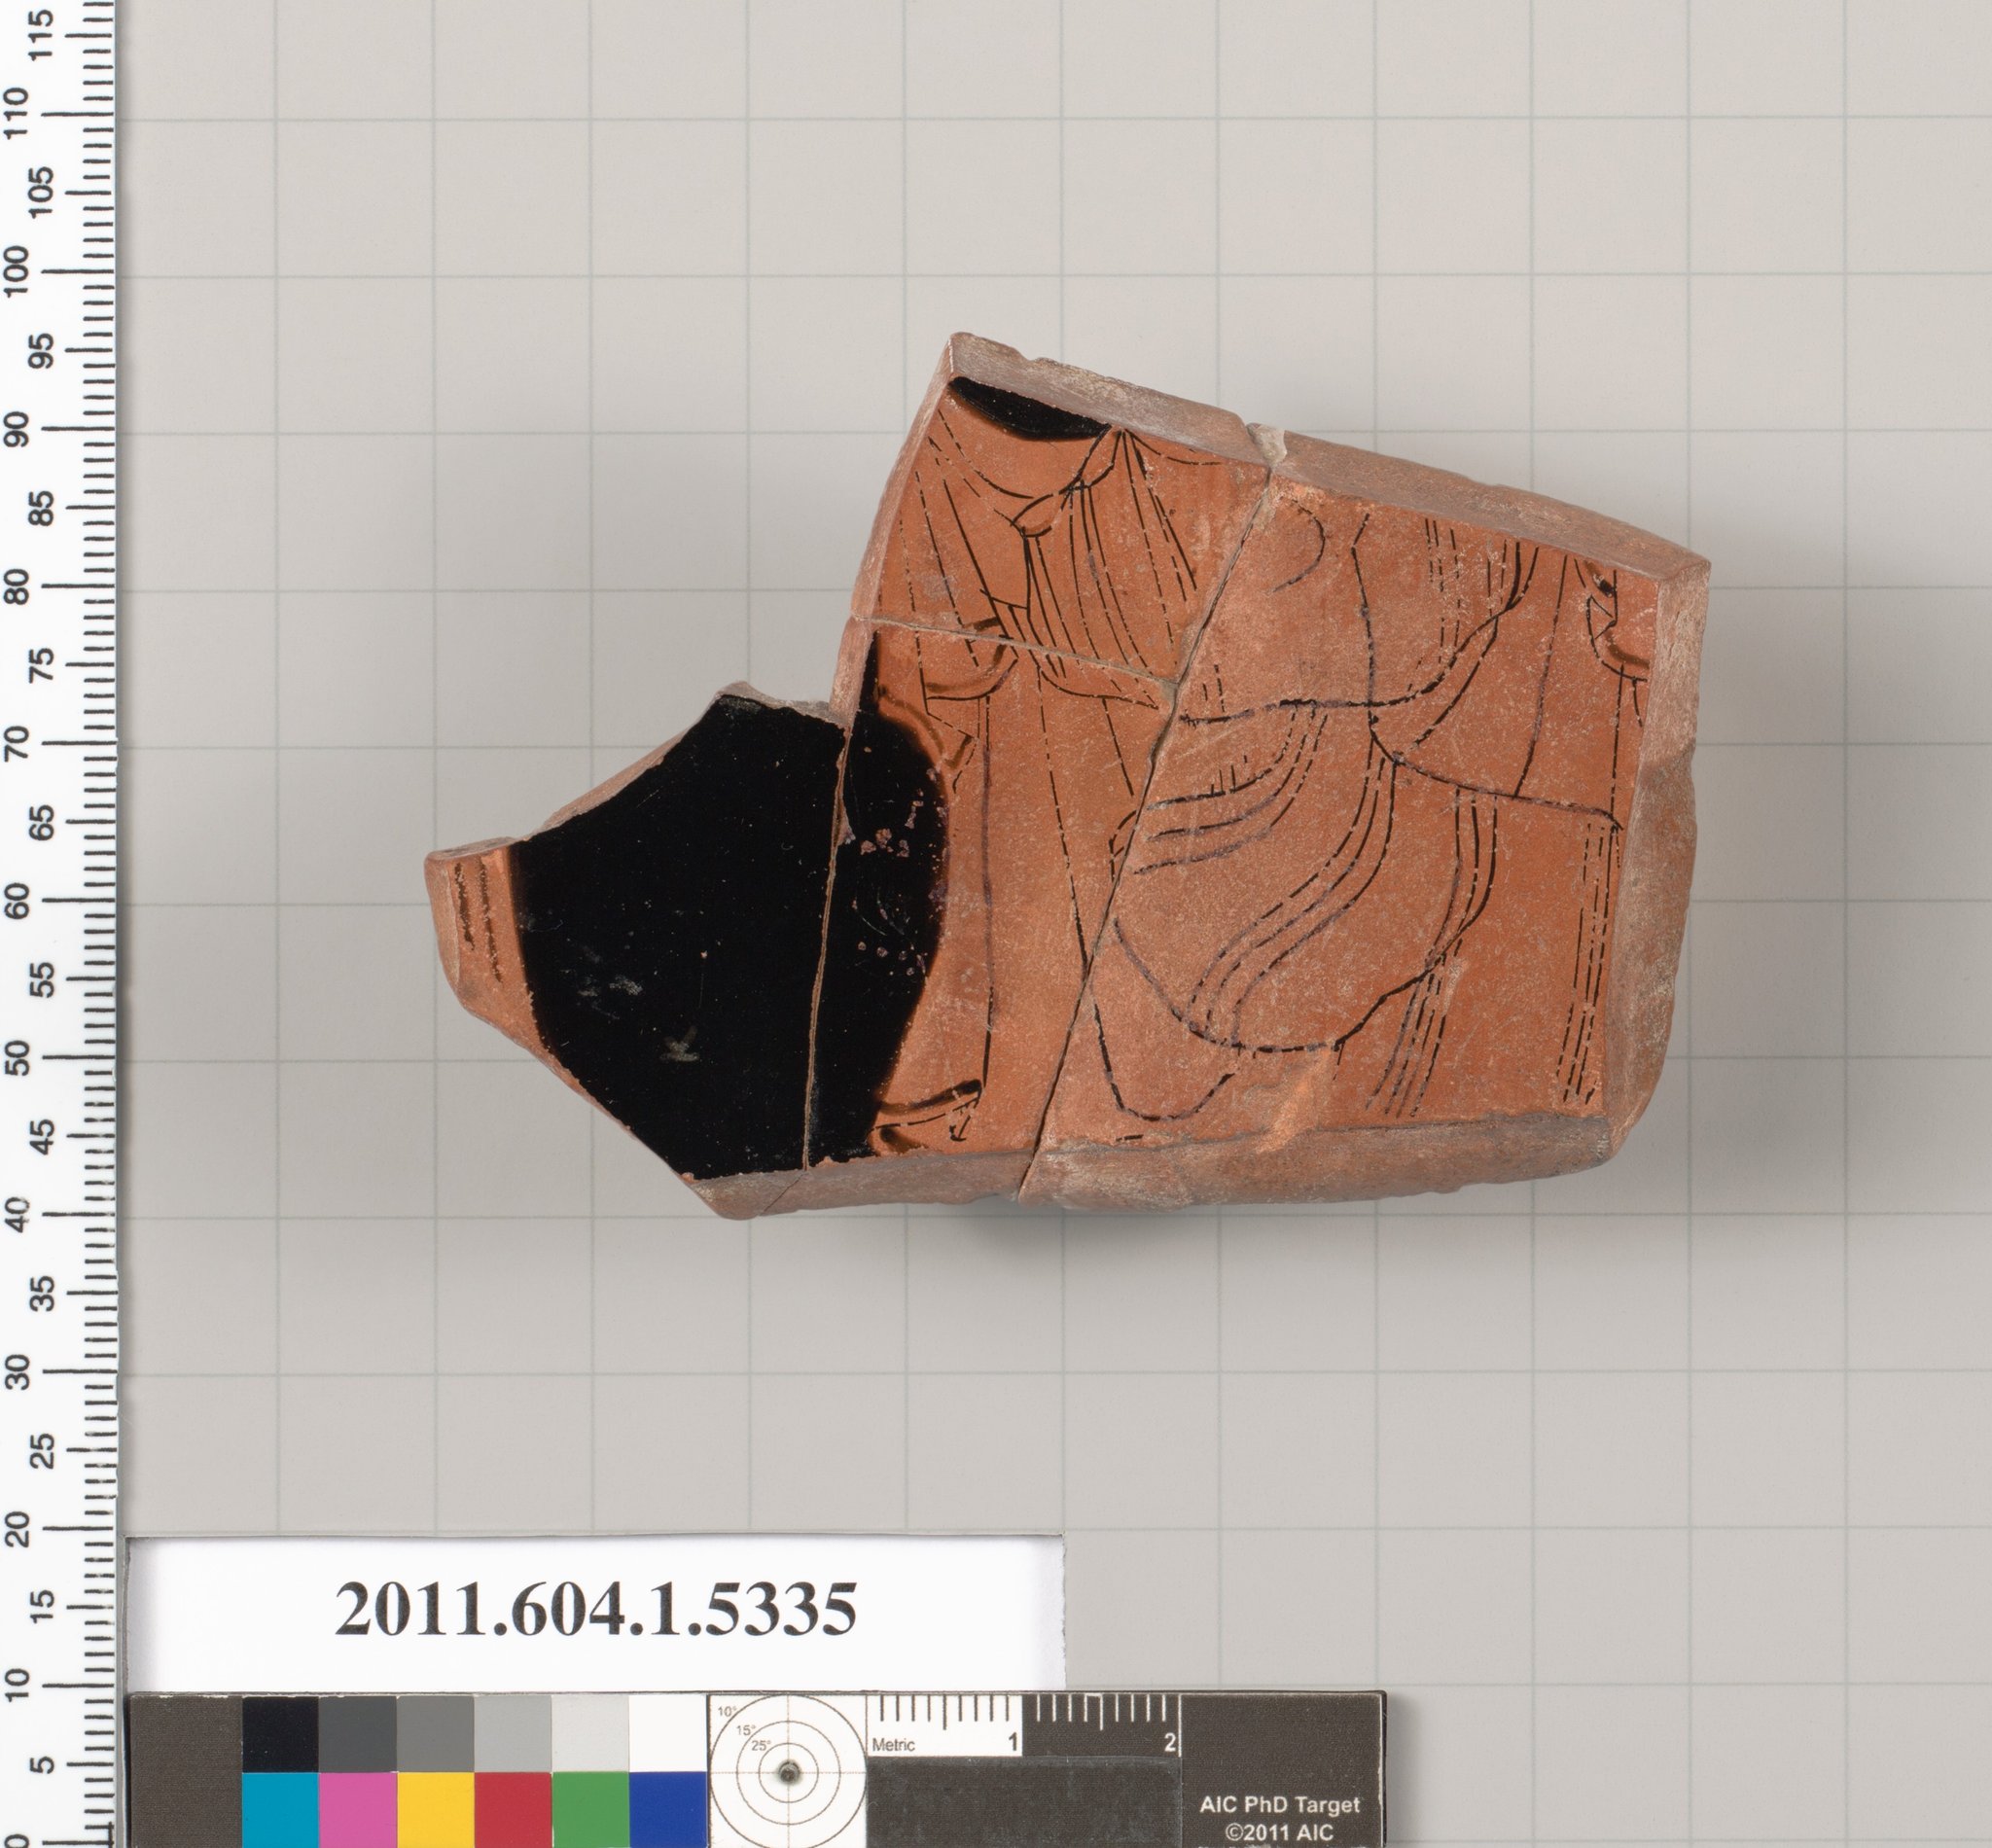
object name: kylix fragment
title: Terracotta fragment of a kylix (drinking cup)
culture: greek, attic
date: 475-451 BCE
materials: terracotta